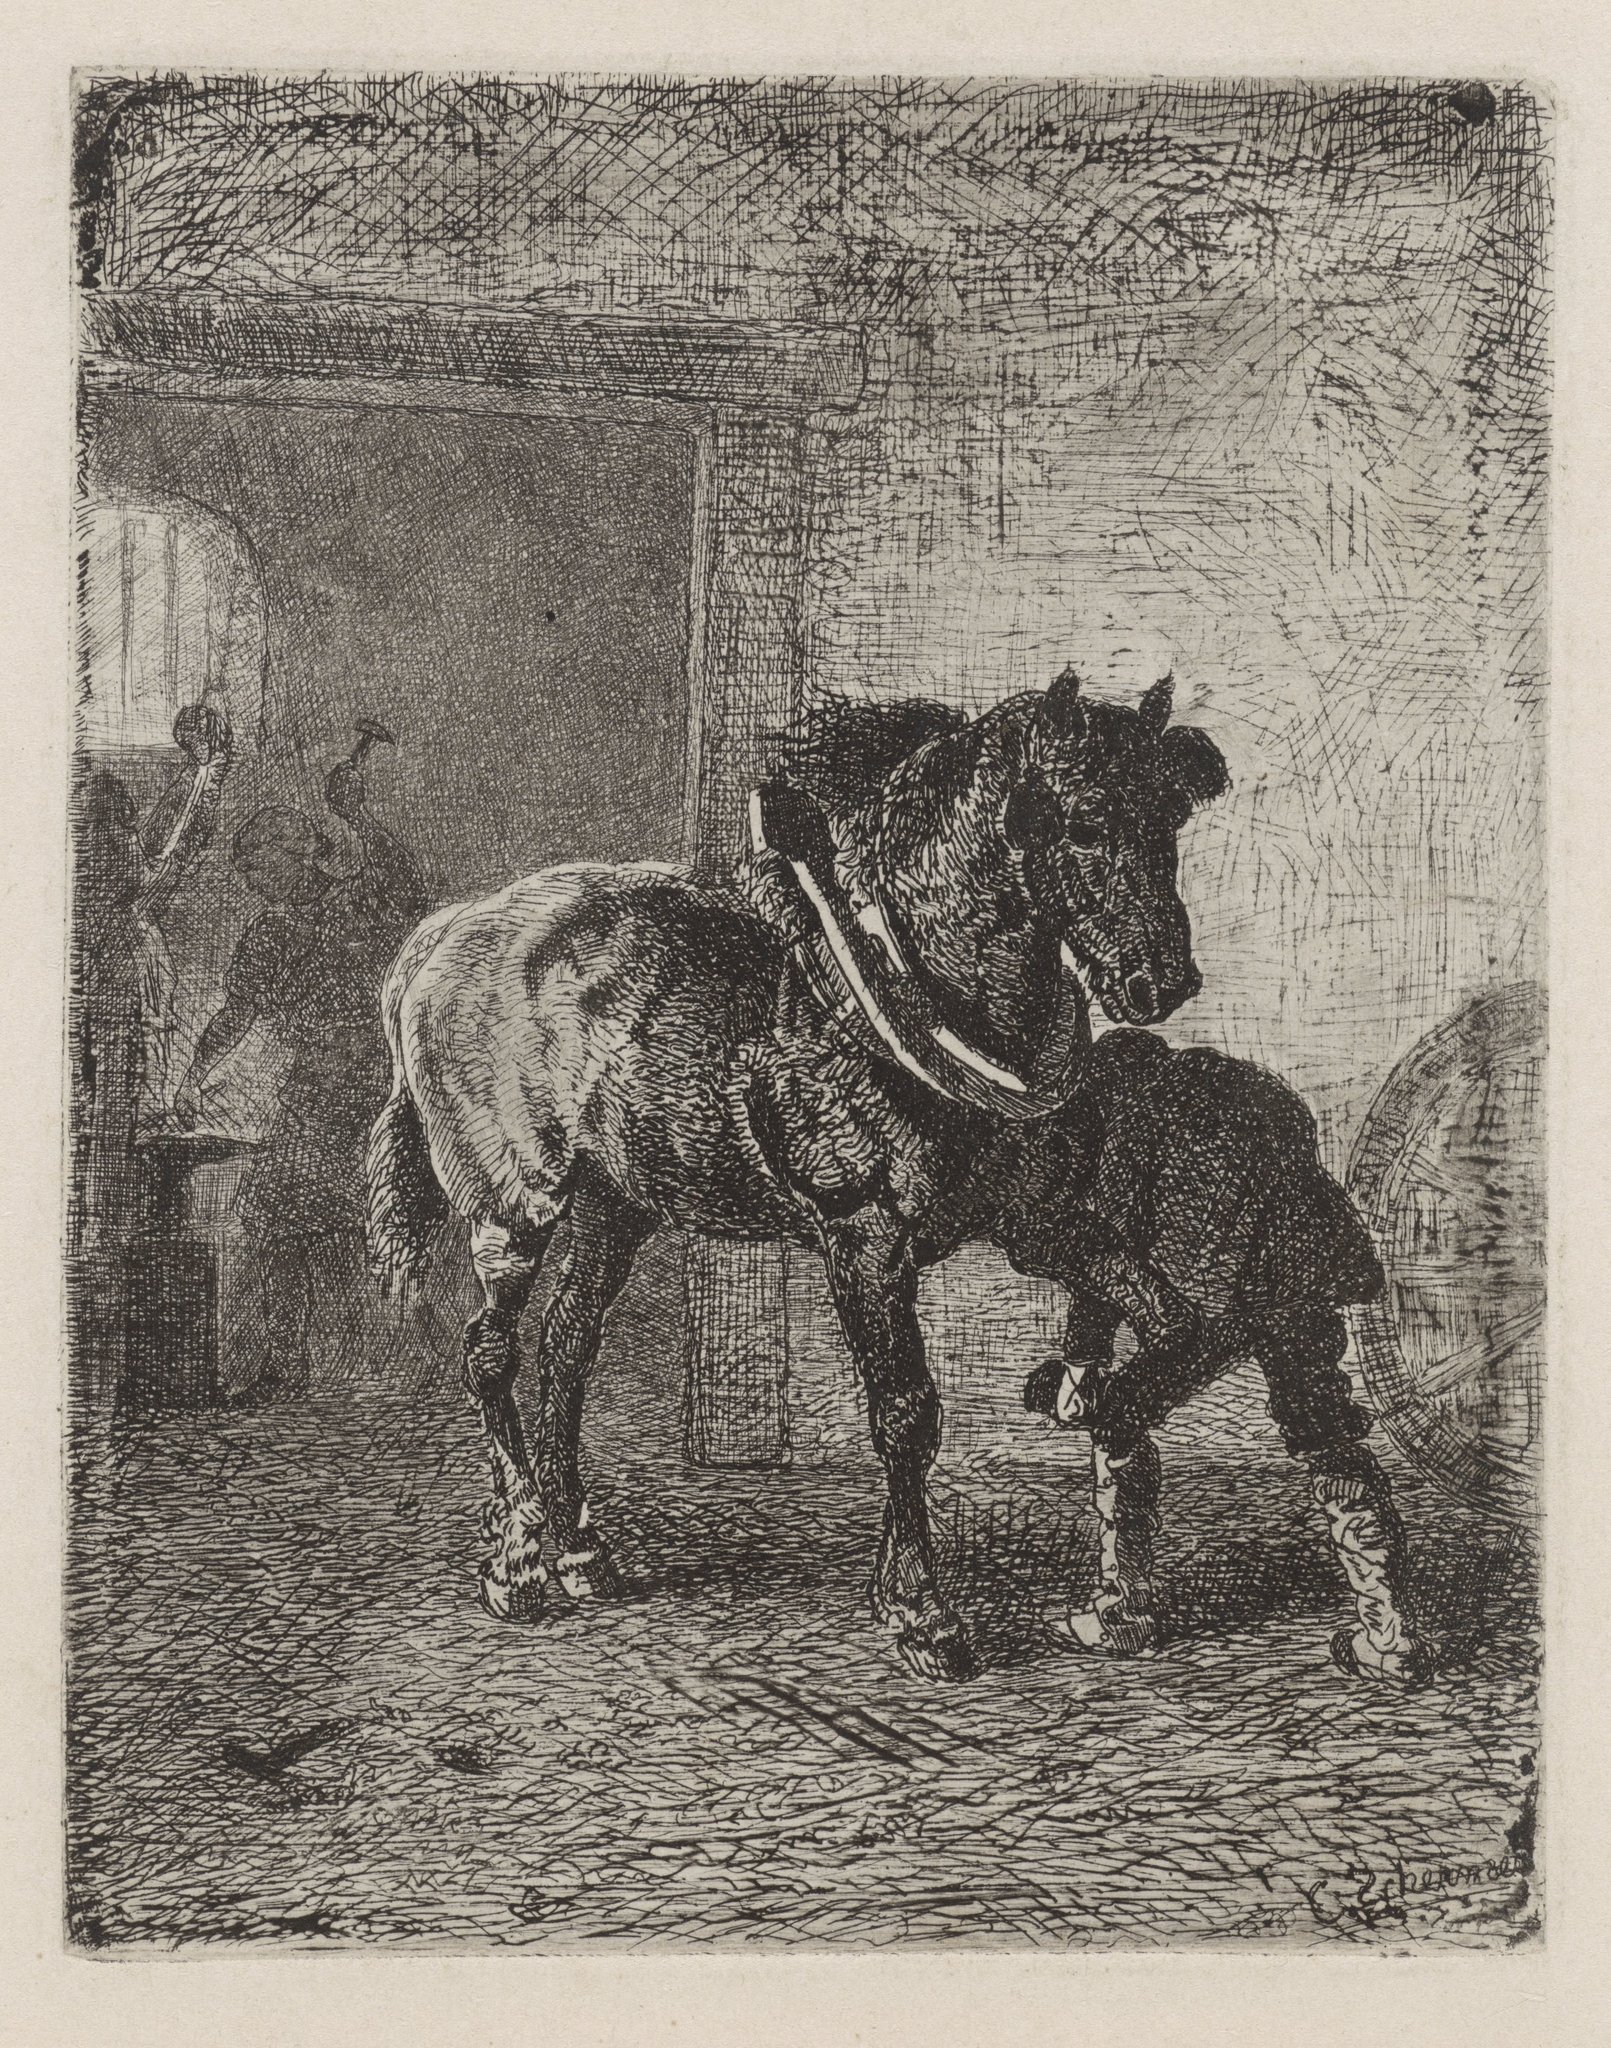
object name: print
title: Paard krijgt hoefijzers in een smederij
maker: cornelis albertus johannes schermer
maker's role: draughtsman, painter, print maker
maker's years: 1824-1915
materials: paper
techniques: etching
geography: the hague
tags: farrier, shoeing-smith, horse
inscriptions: collector's mark: Lugt 2228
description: Vooraan beslaat een man de hoef van een paard. Achter hem is een smid in een smederij aan het werk bij een aambeeld.